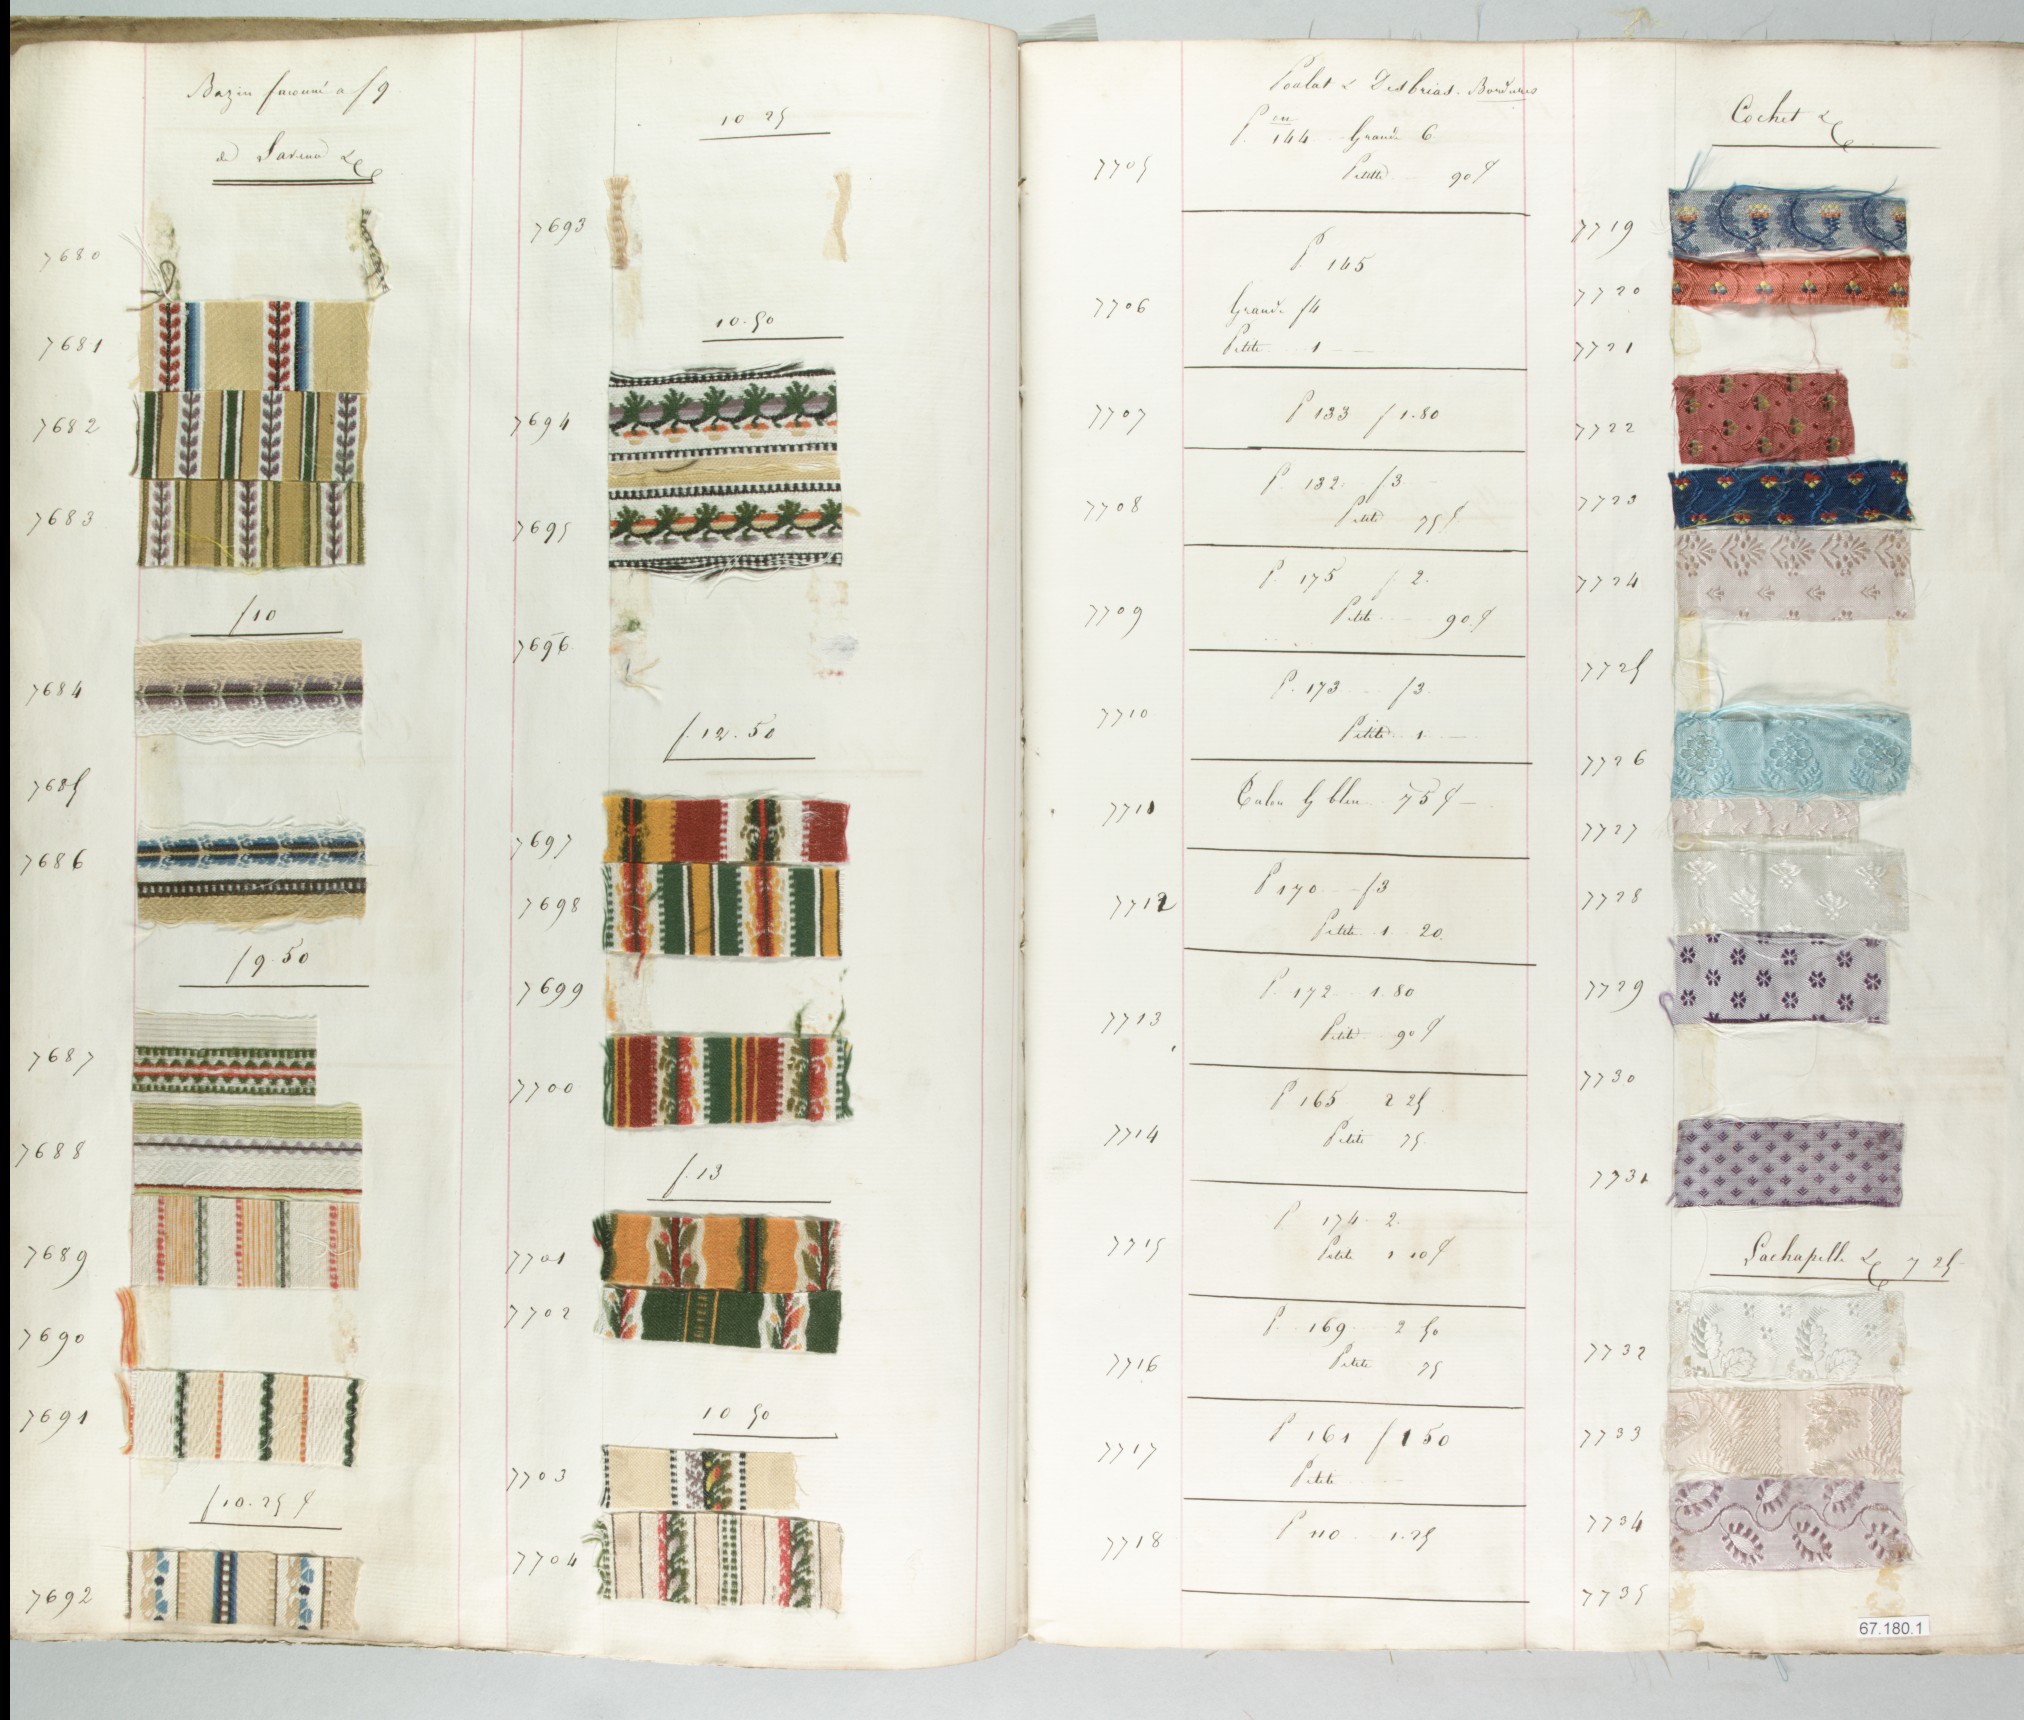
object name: sample book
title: Textile Sample Book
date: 1818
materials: paper, silk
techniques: weave